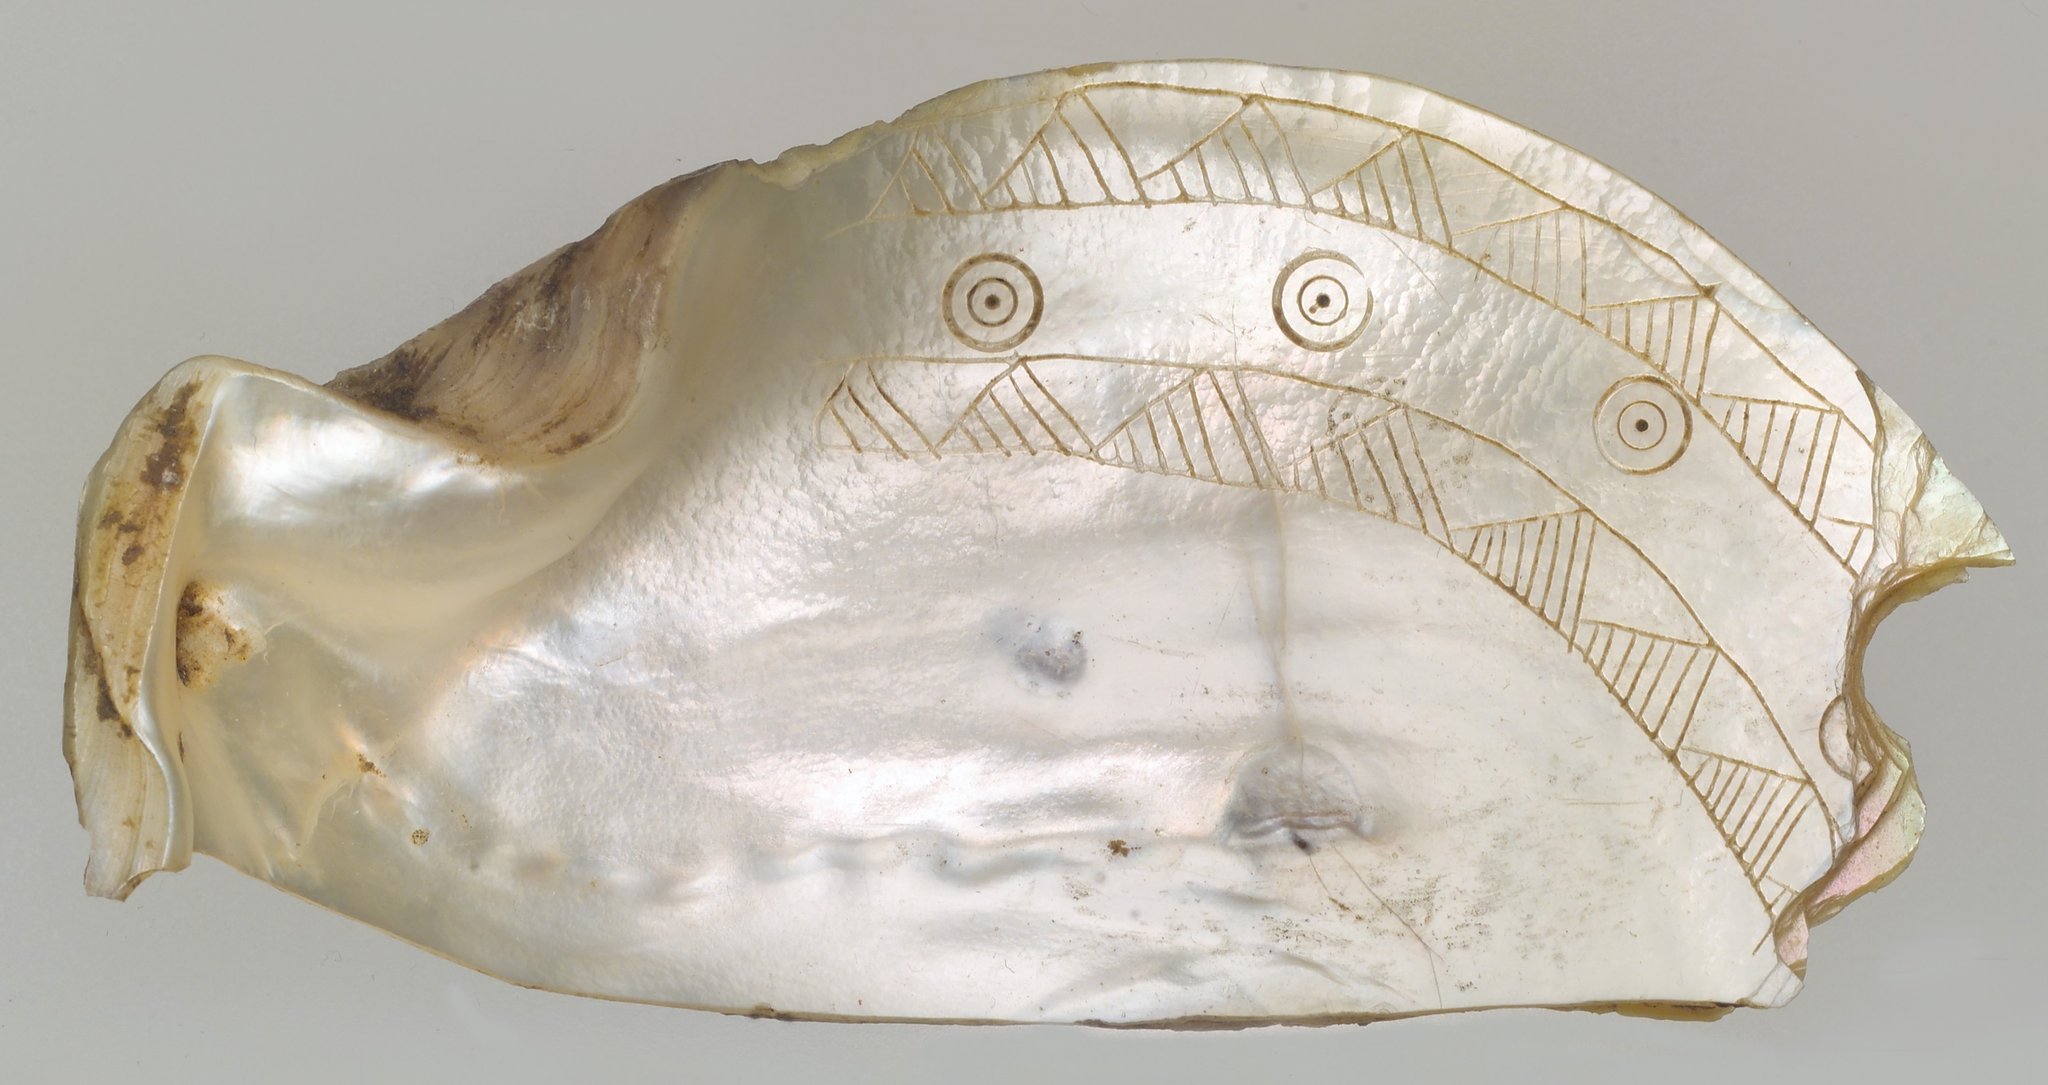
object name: shell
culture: sasanian or islamic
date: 501-800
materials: shell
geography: iran